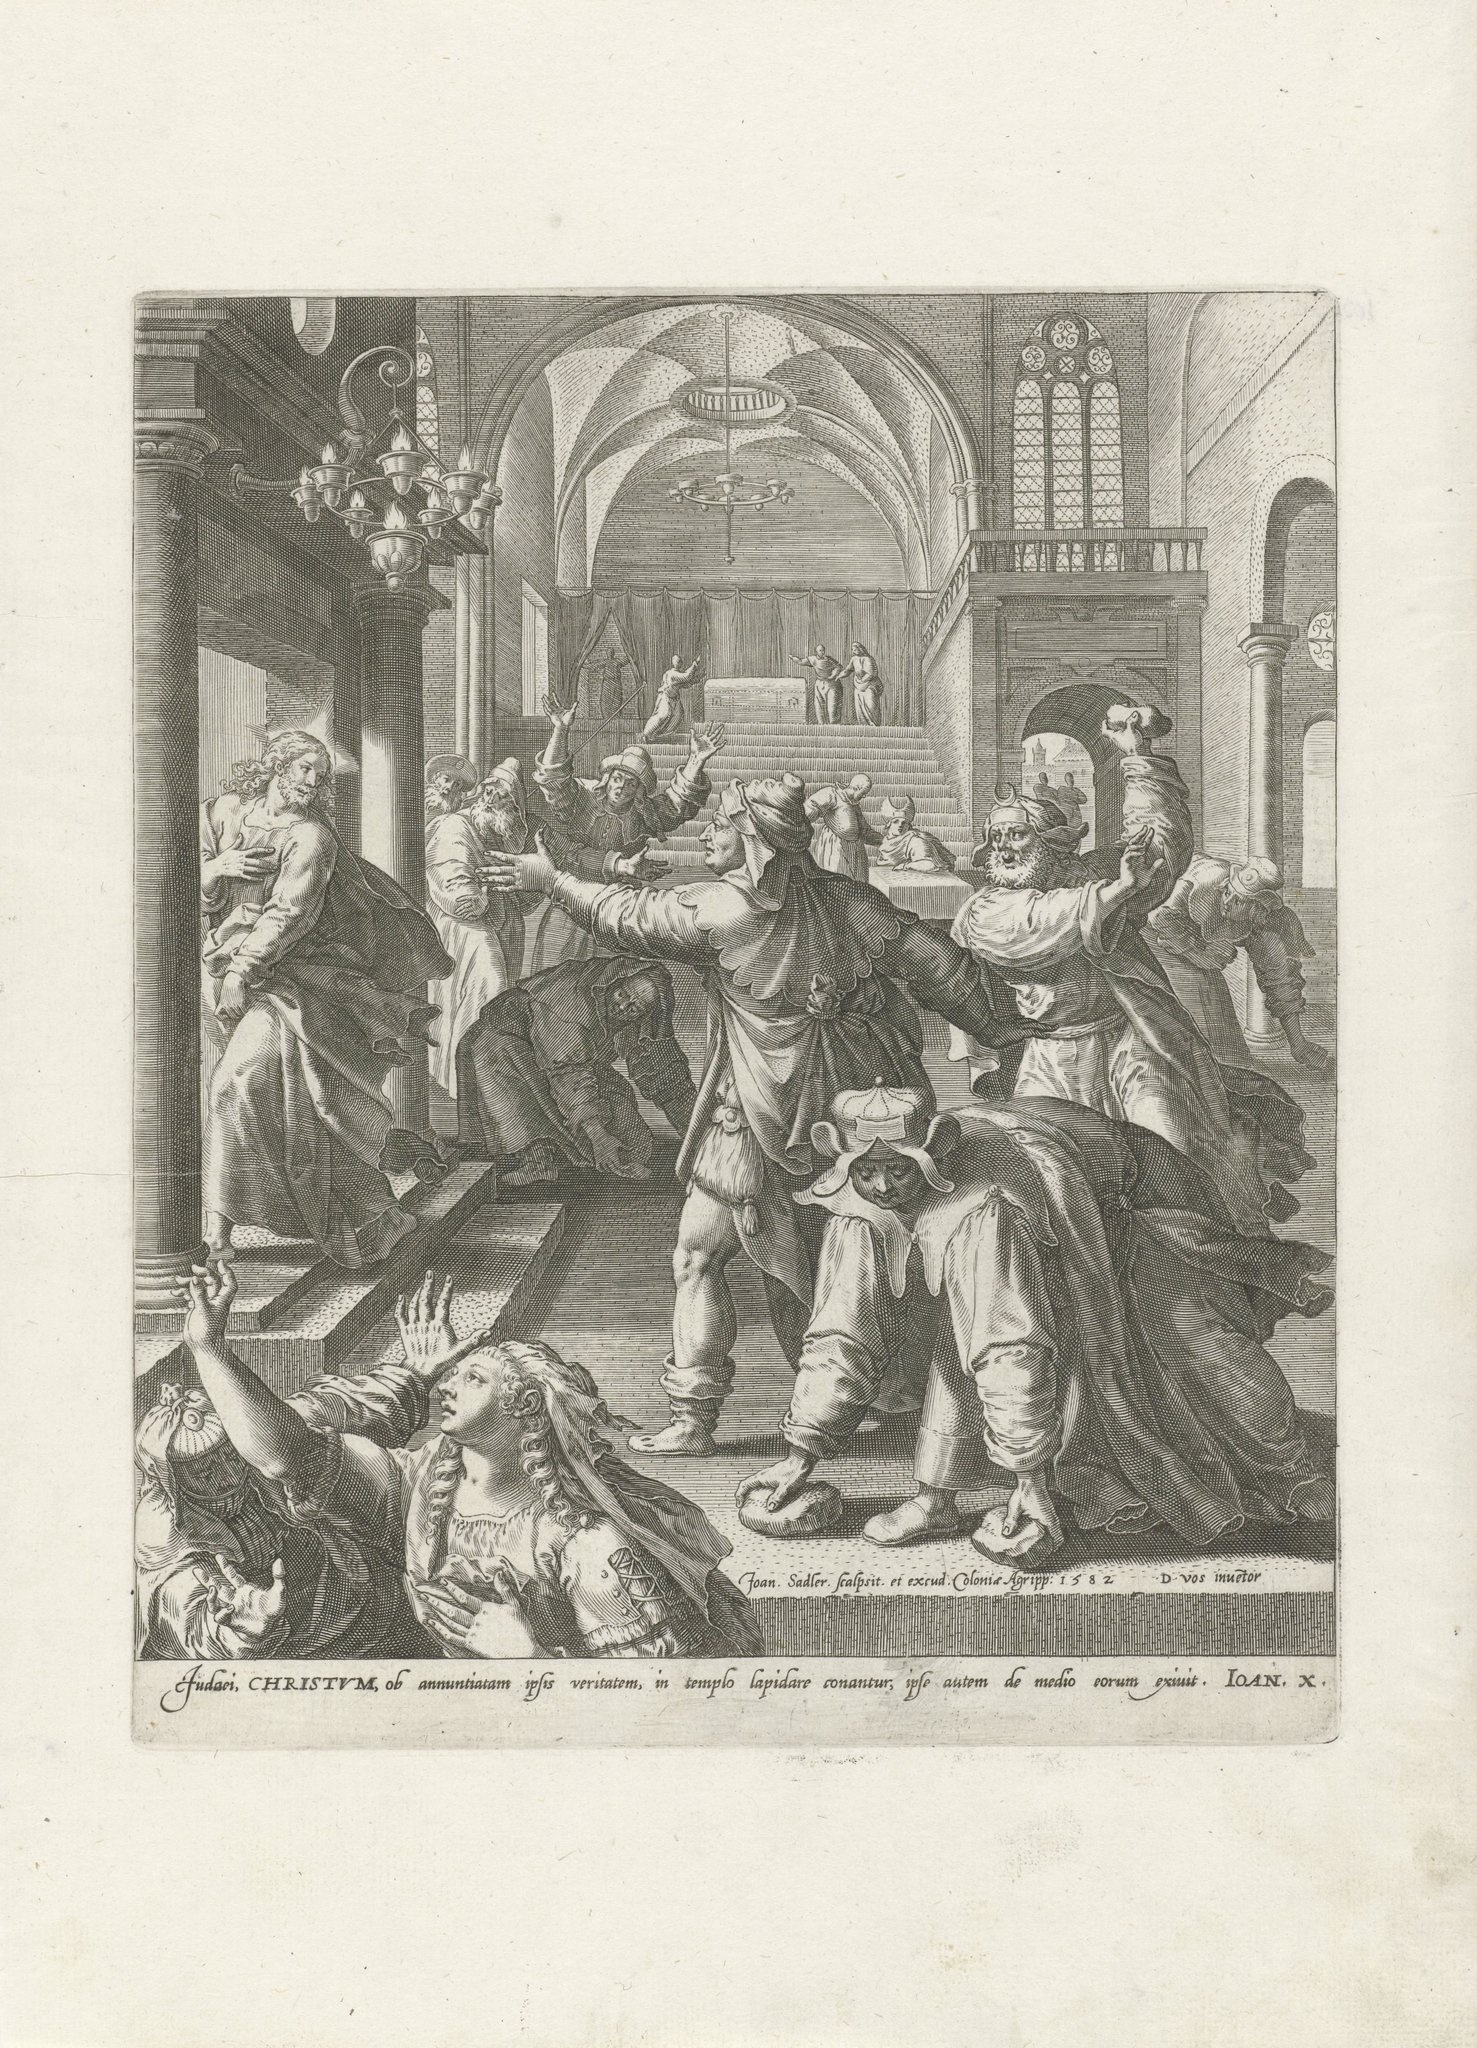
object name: print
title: Steniging van Christus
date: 1582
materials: paper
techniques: engraving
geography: cologne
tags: attempts to stone christ (john 8:59, 10:31-33)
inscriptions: collector's mark: Lugt 2760, collector's mark: Lugt 2228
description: Christus verlaat de tempel van Jeruzalem omdat de Joden hem willen stenigen. Op de voorgrond worden stenen opgeraapt door enkele mannen. De prent heeft een Latijns onderschrift met een Bijbeltekst (Joh. 10) en is de laatste prent van een serie van vier.